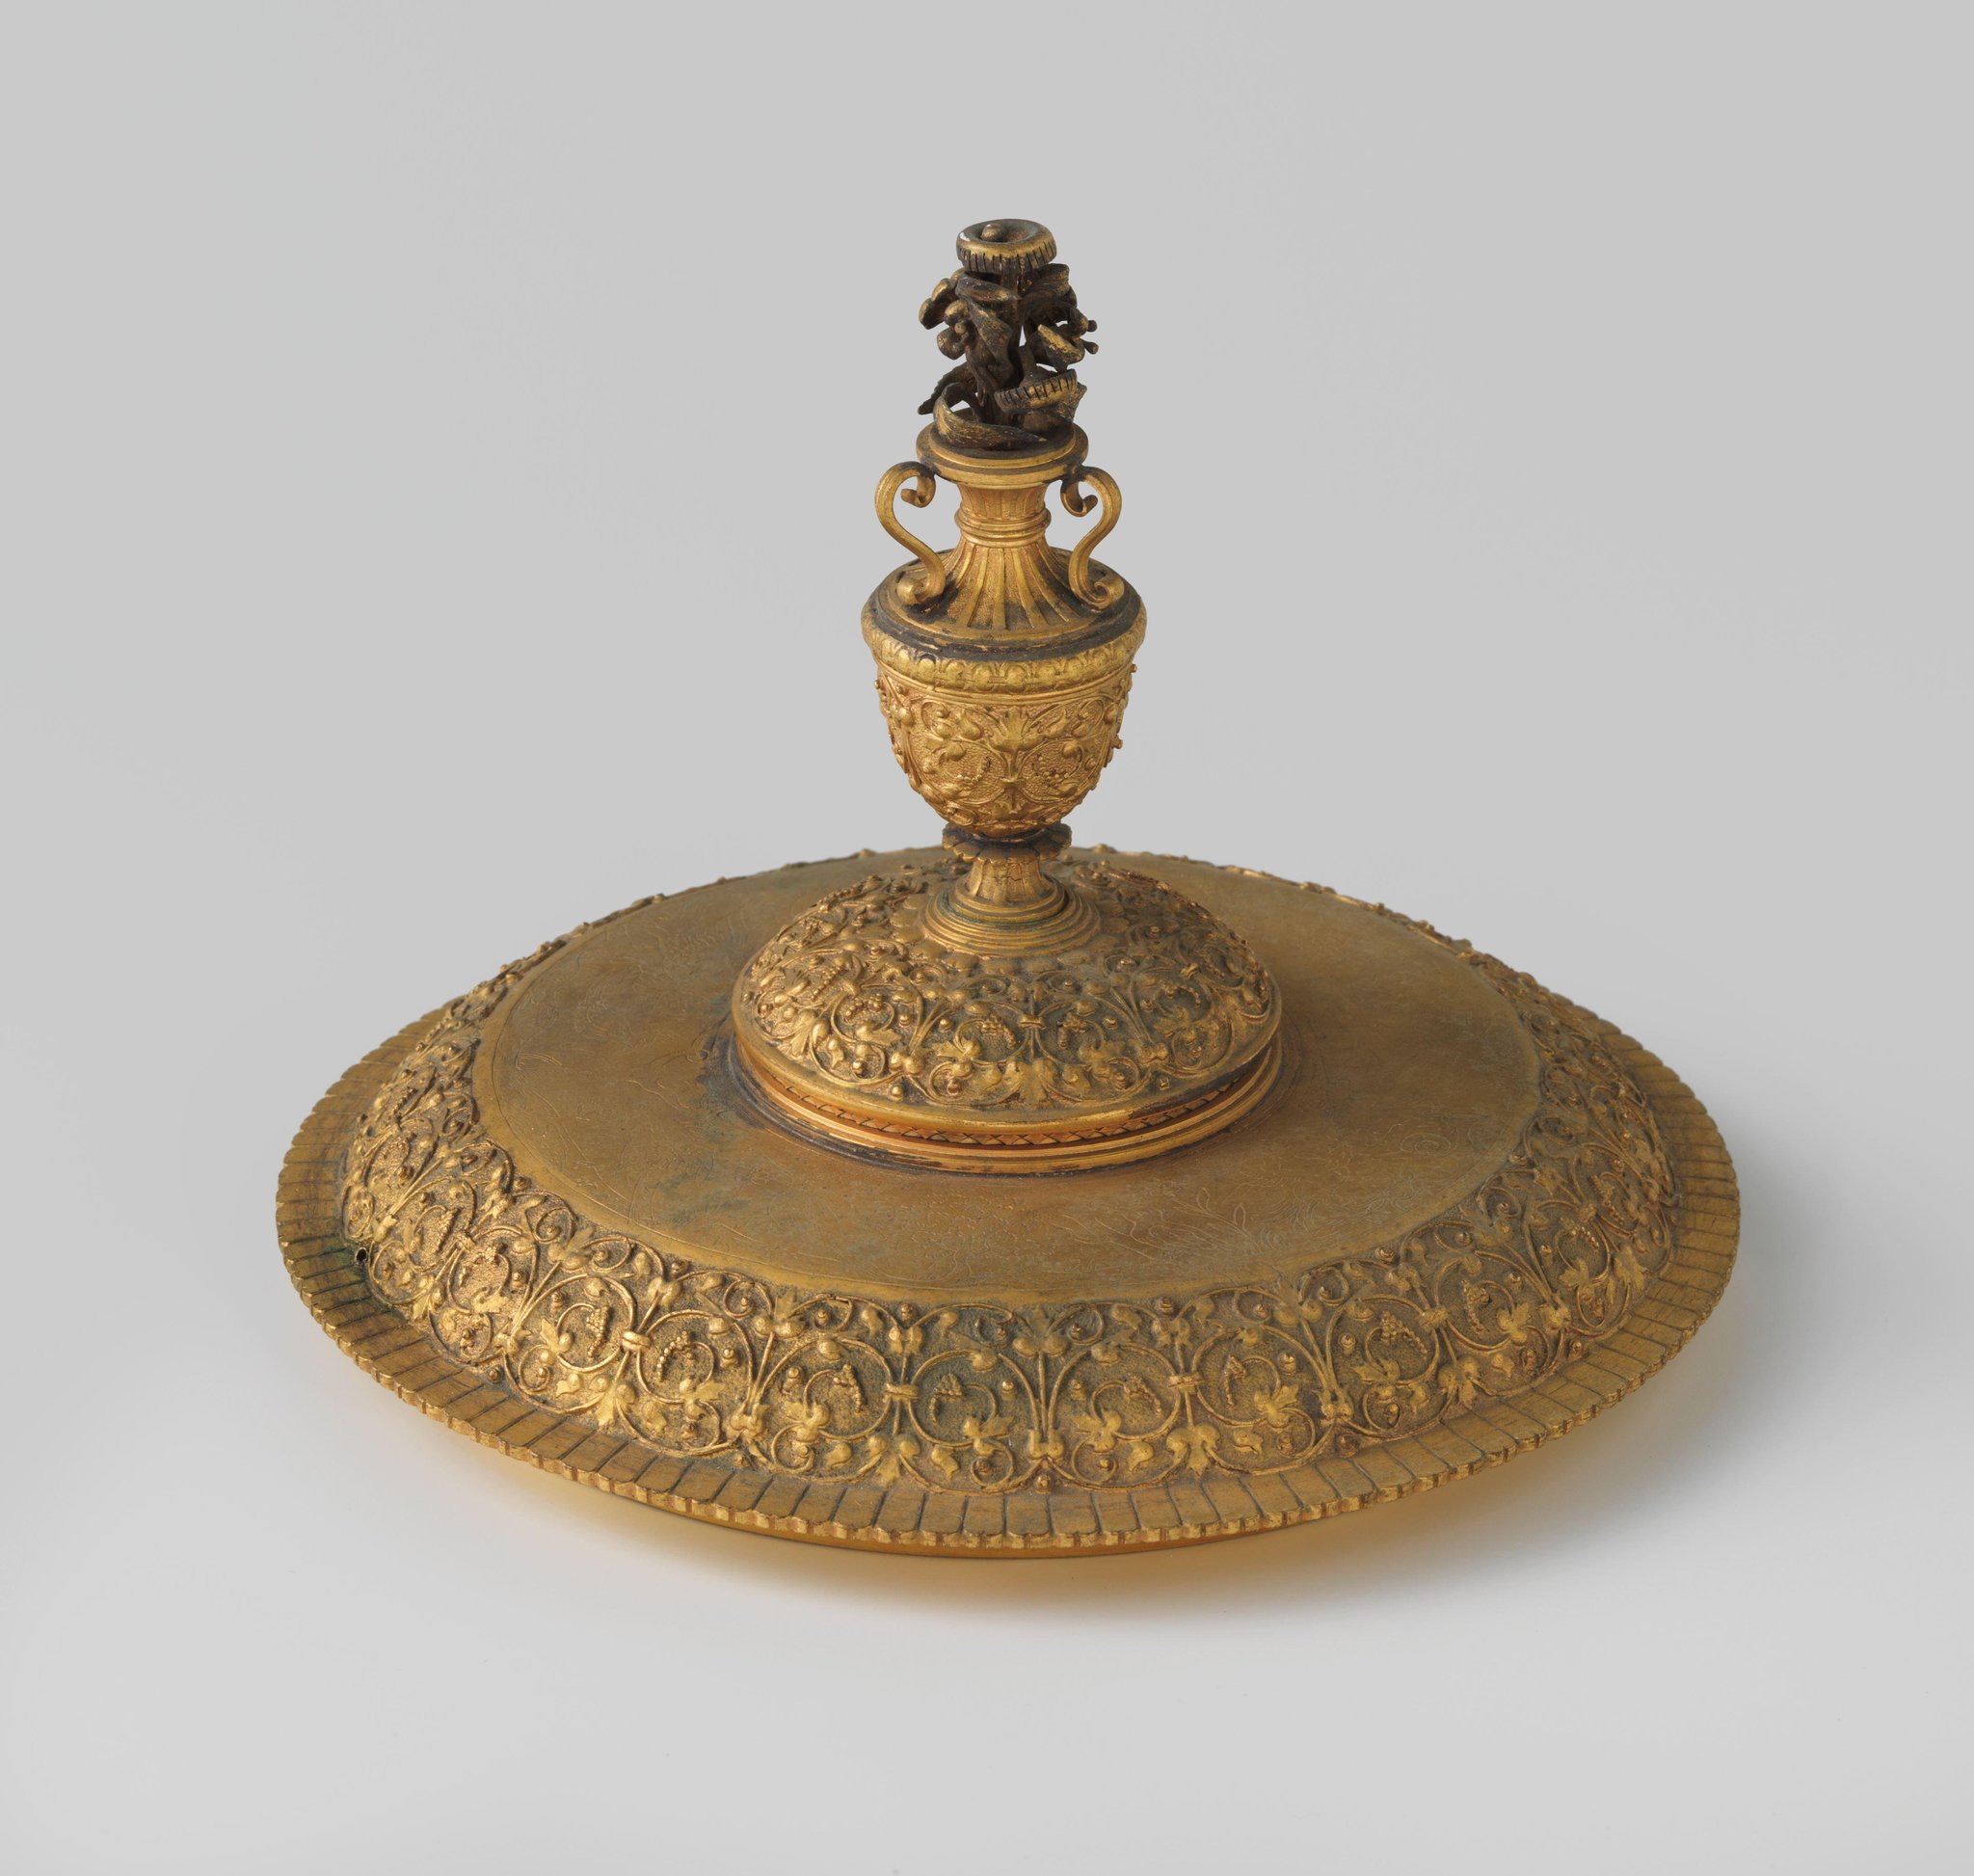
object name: goblet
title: Galvanoplastische reproductie van een bokaal met deksel met scènes gerelateerd aan de jacht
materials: copper, silver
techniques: gilding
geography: london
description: Galvanoplastische reproductie van een bokaal met deksel, met banden met gegraveerde scènes met onderwerpen gerelateerd aan de jacht afgewisseld met banden met rolwerk in relief; een vaas met bloemen vormt de bekroning van het deksel.